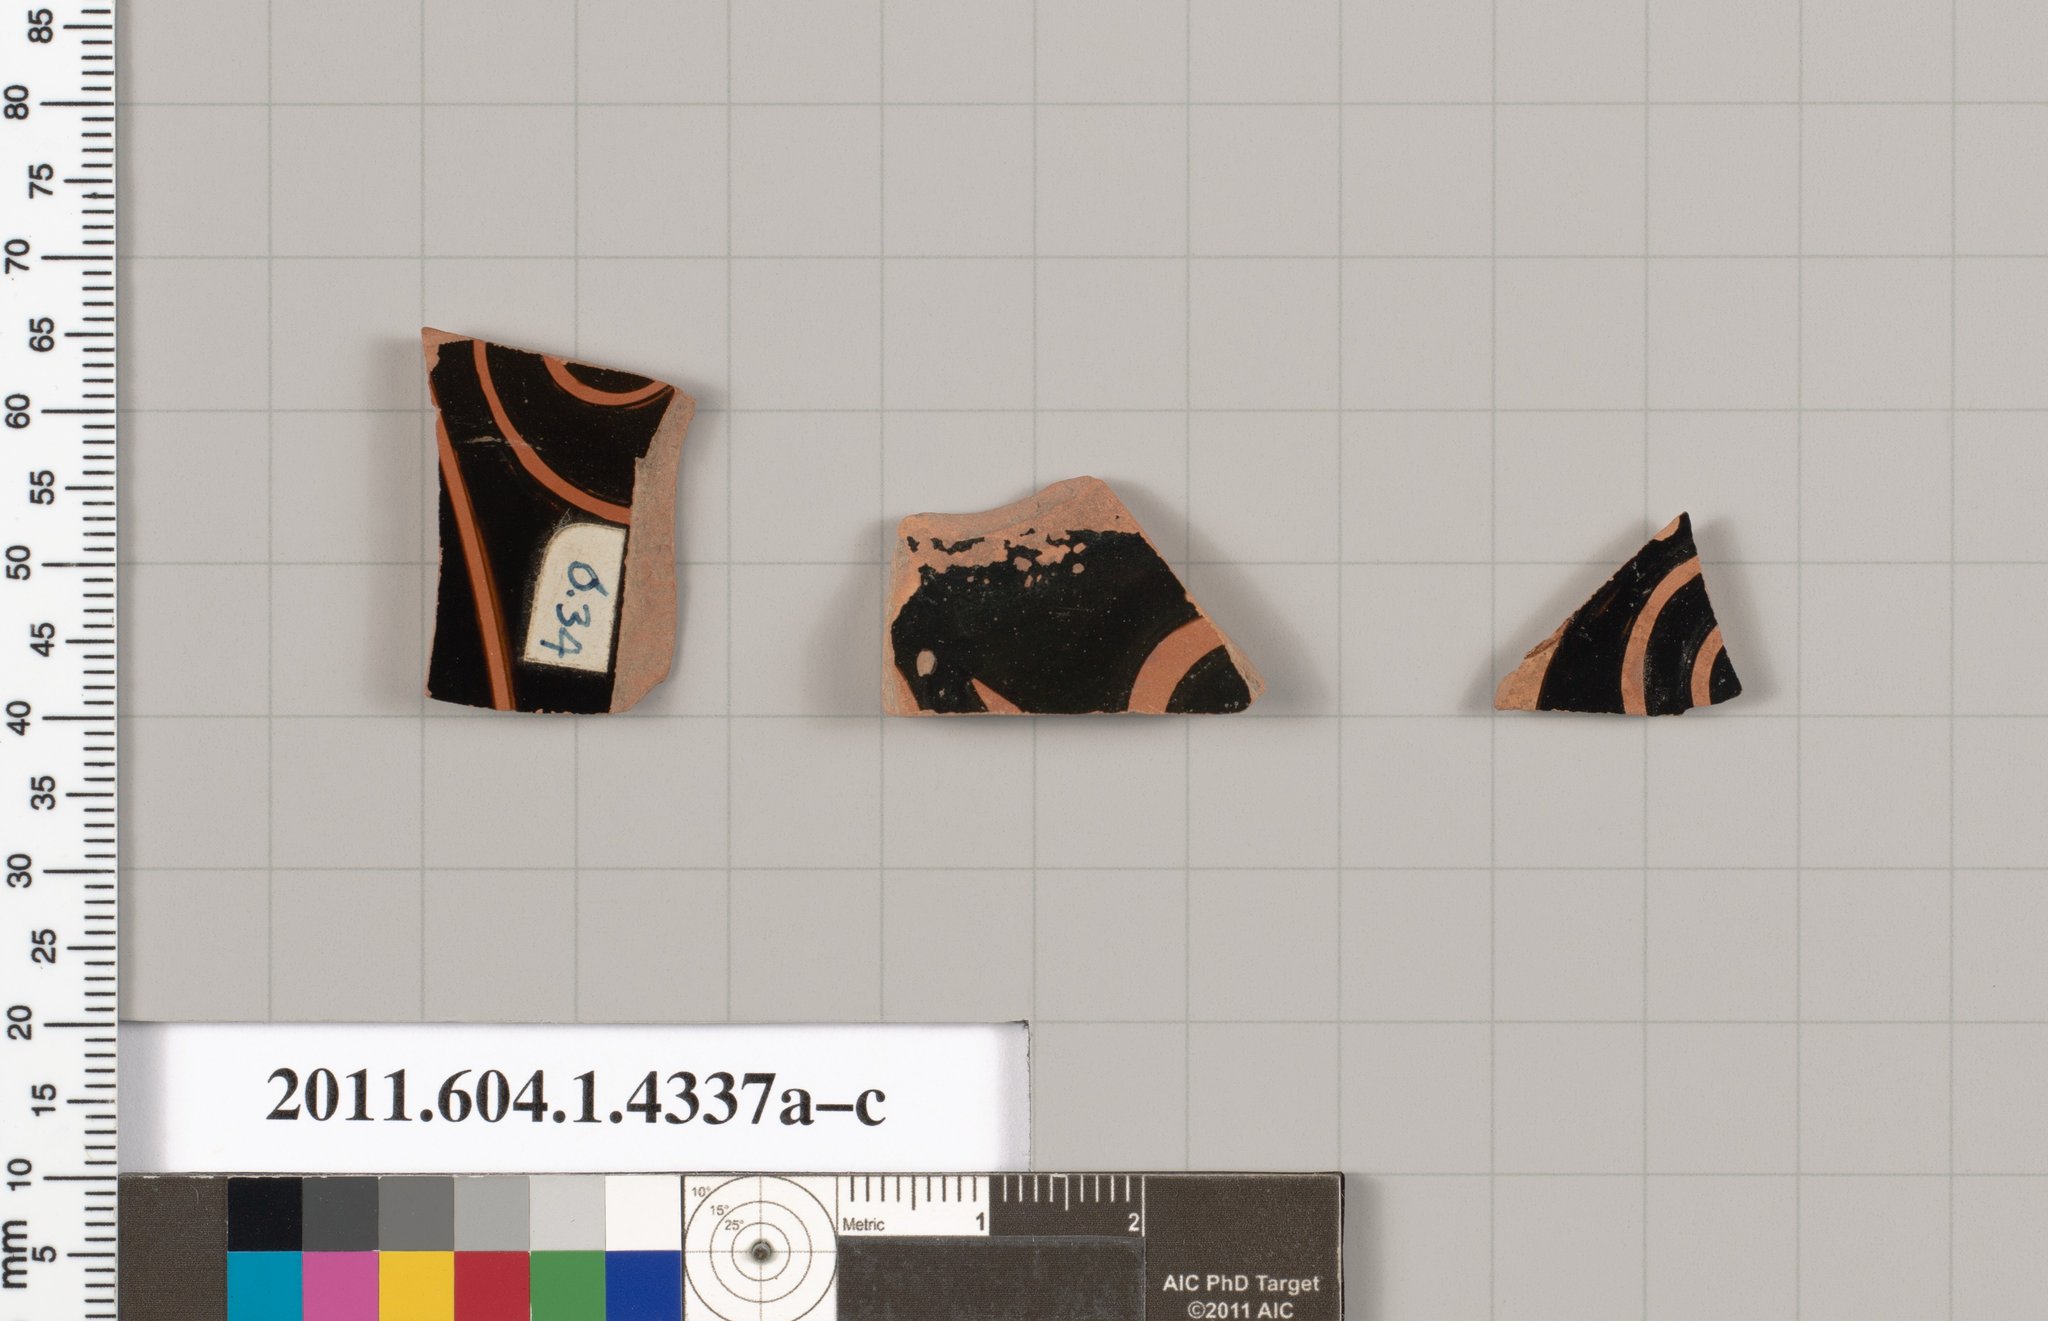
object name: kylix fragment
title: Terracotta fragments of kylikes (drinking cups)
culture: greek, attic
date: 500-451 BCE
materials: terracotta